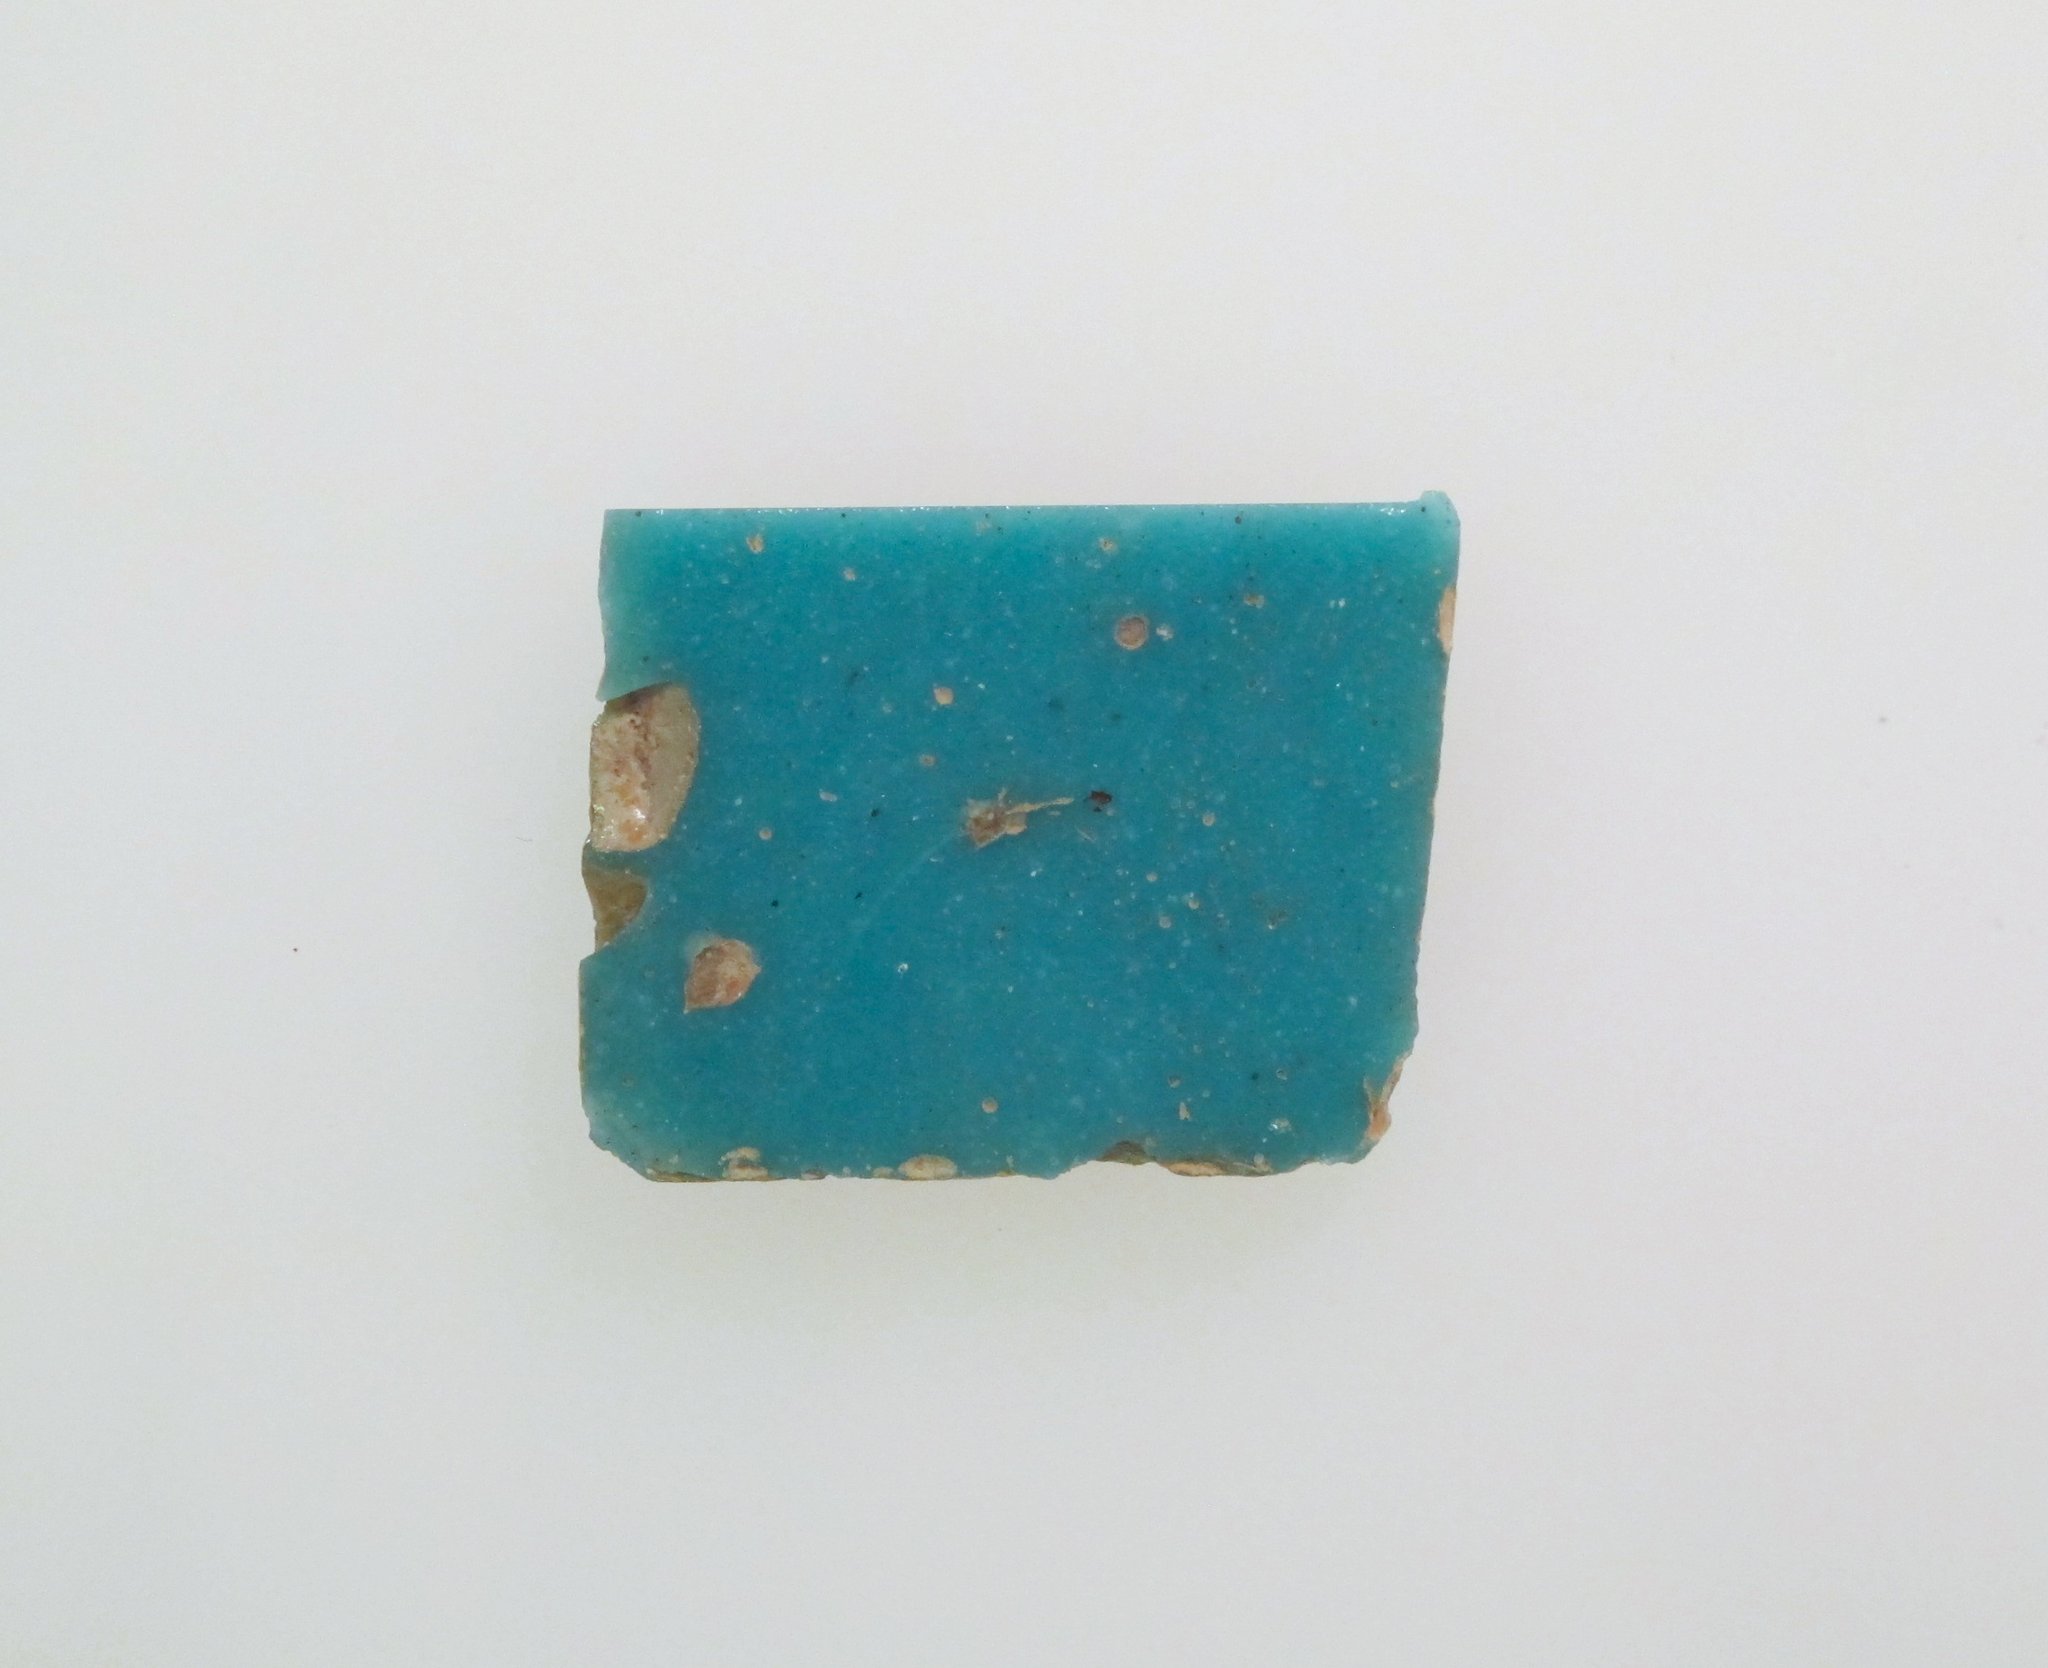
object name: fragment, monochrome inlay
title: Glass monochrome inlay fragment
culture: roman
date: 1-50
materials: glass